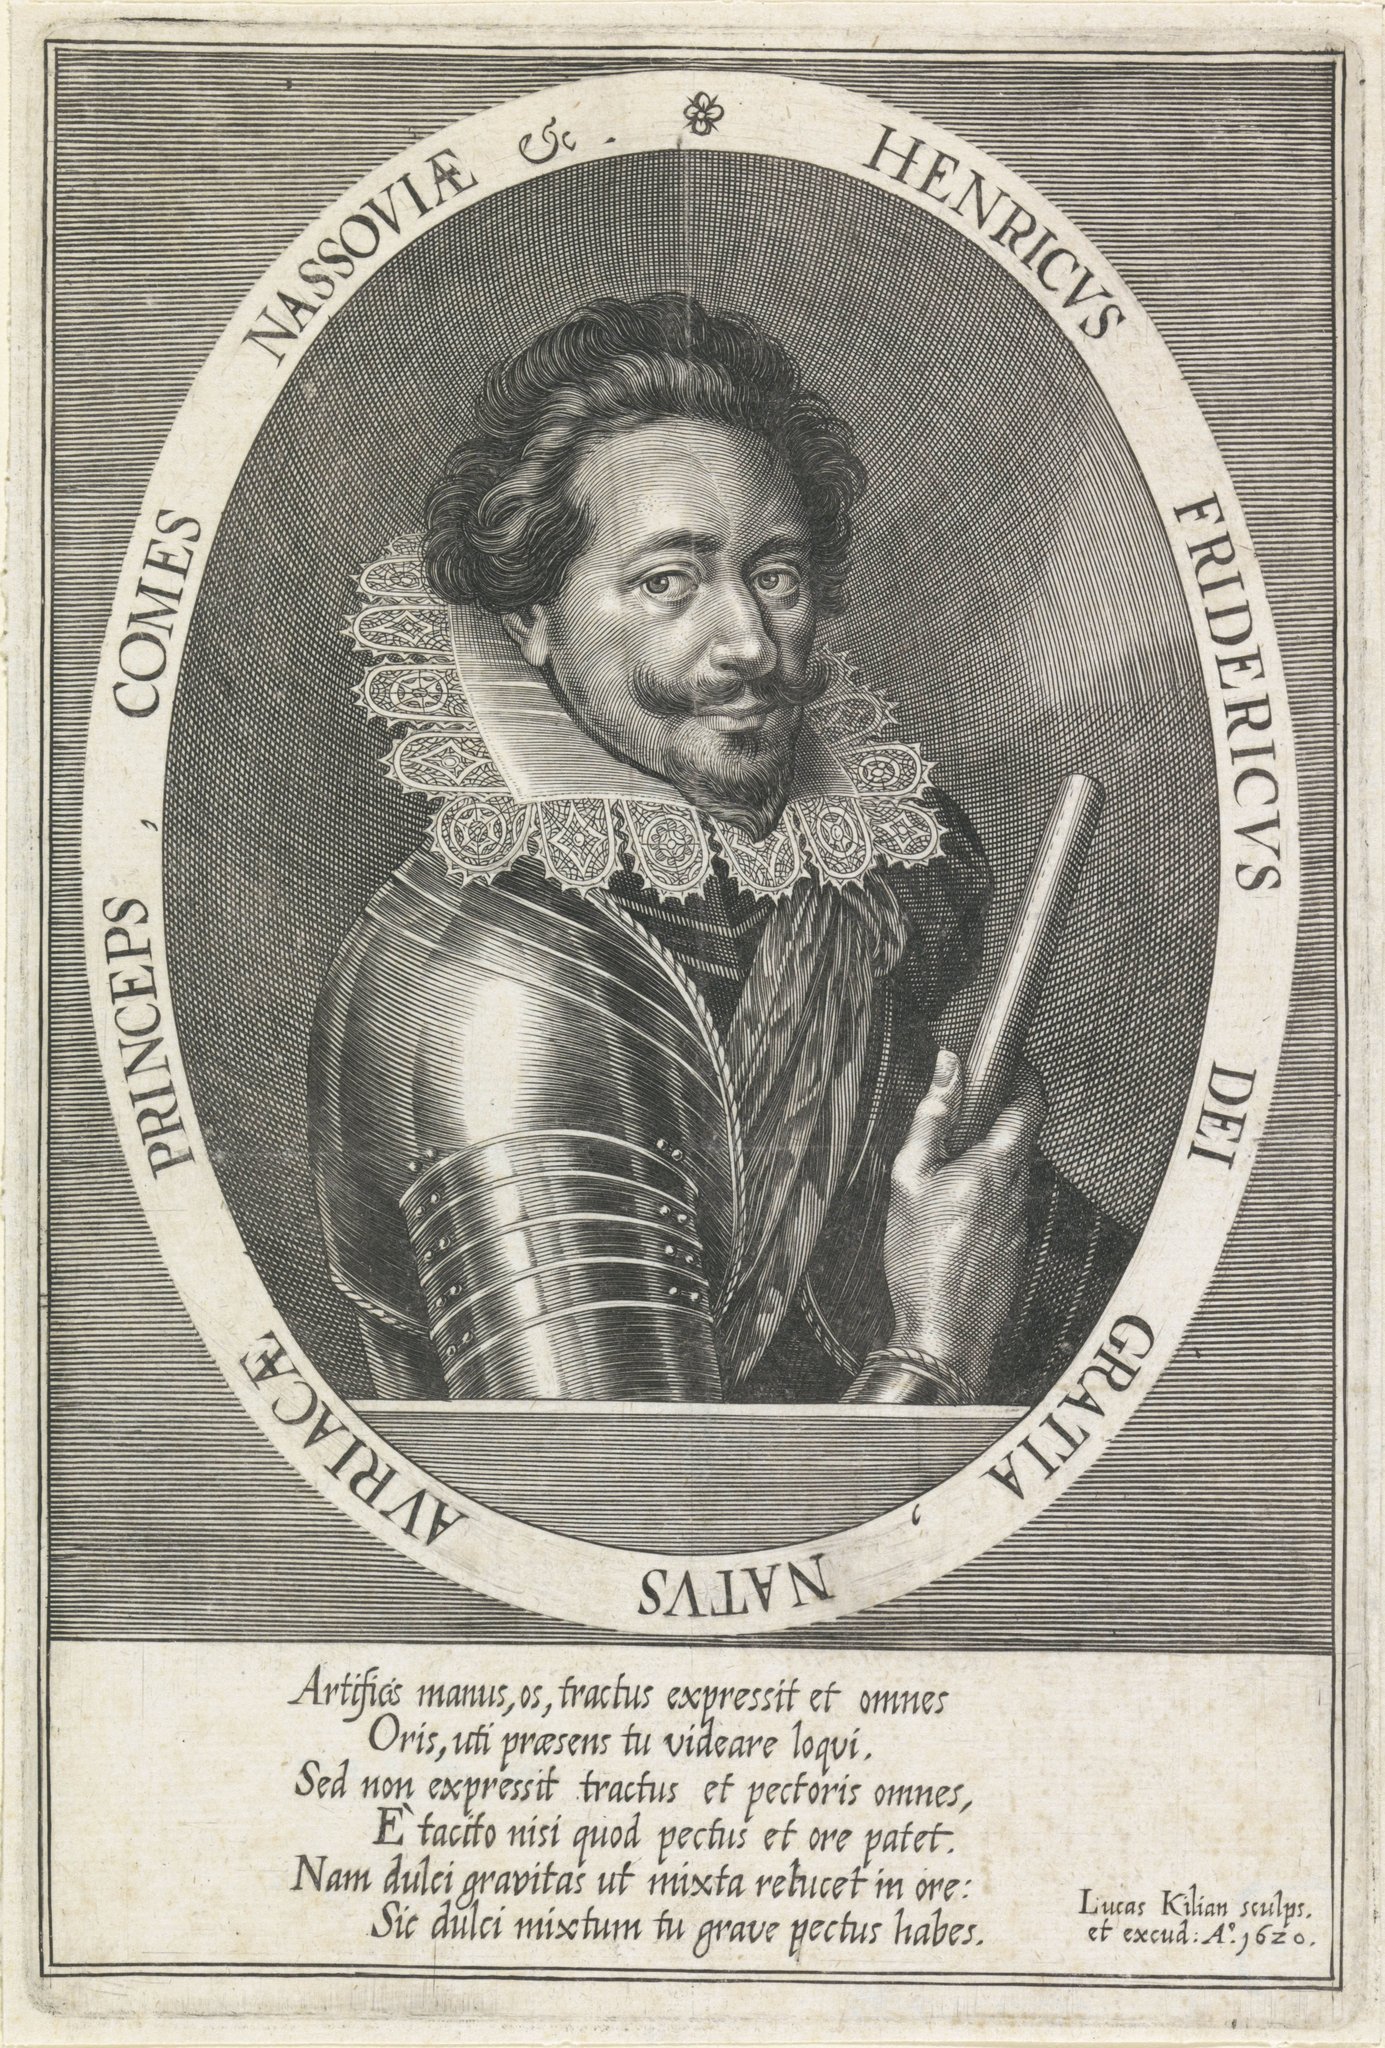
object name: print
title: Portret van Frederik Hendrik, prins van Oranje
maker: lucas kilian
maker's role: draughtsman, print maker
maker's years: 1579-1637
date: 1620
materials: paper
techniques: engraving, etching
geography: italy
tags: delft, frederick henry (prince of orange)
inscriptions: collector's mark: Lugt 963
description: De hier vermelde titel verwijst naar de hoogst verkregen titel van de geportretteerde, niet per se naar de titel die de geportretteerde op deze voorstelling draagt.